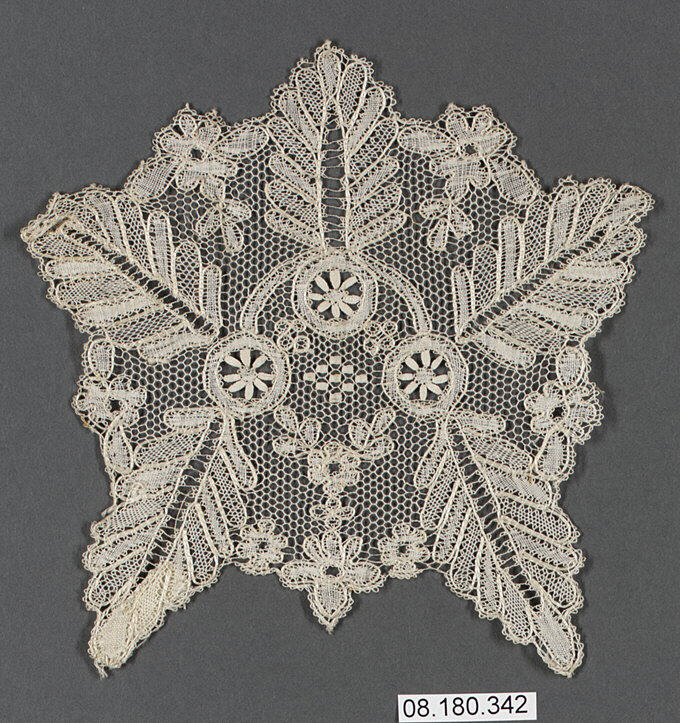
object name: ornament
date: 1801-1900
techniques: lace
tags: flowers,leaves